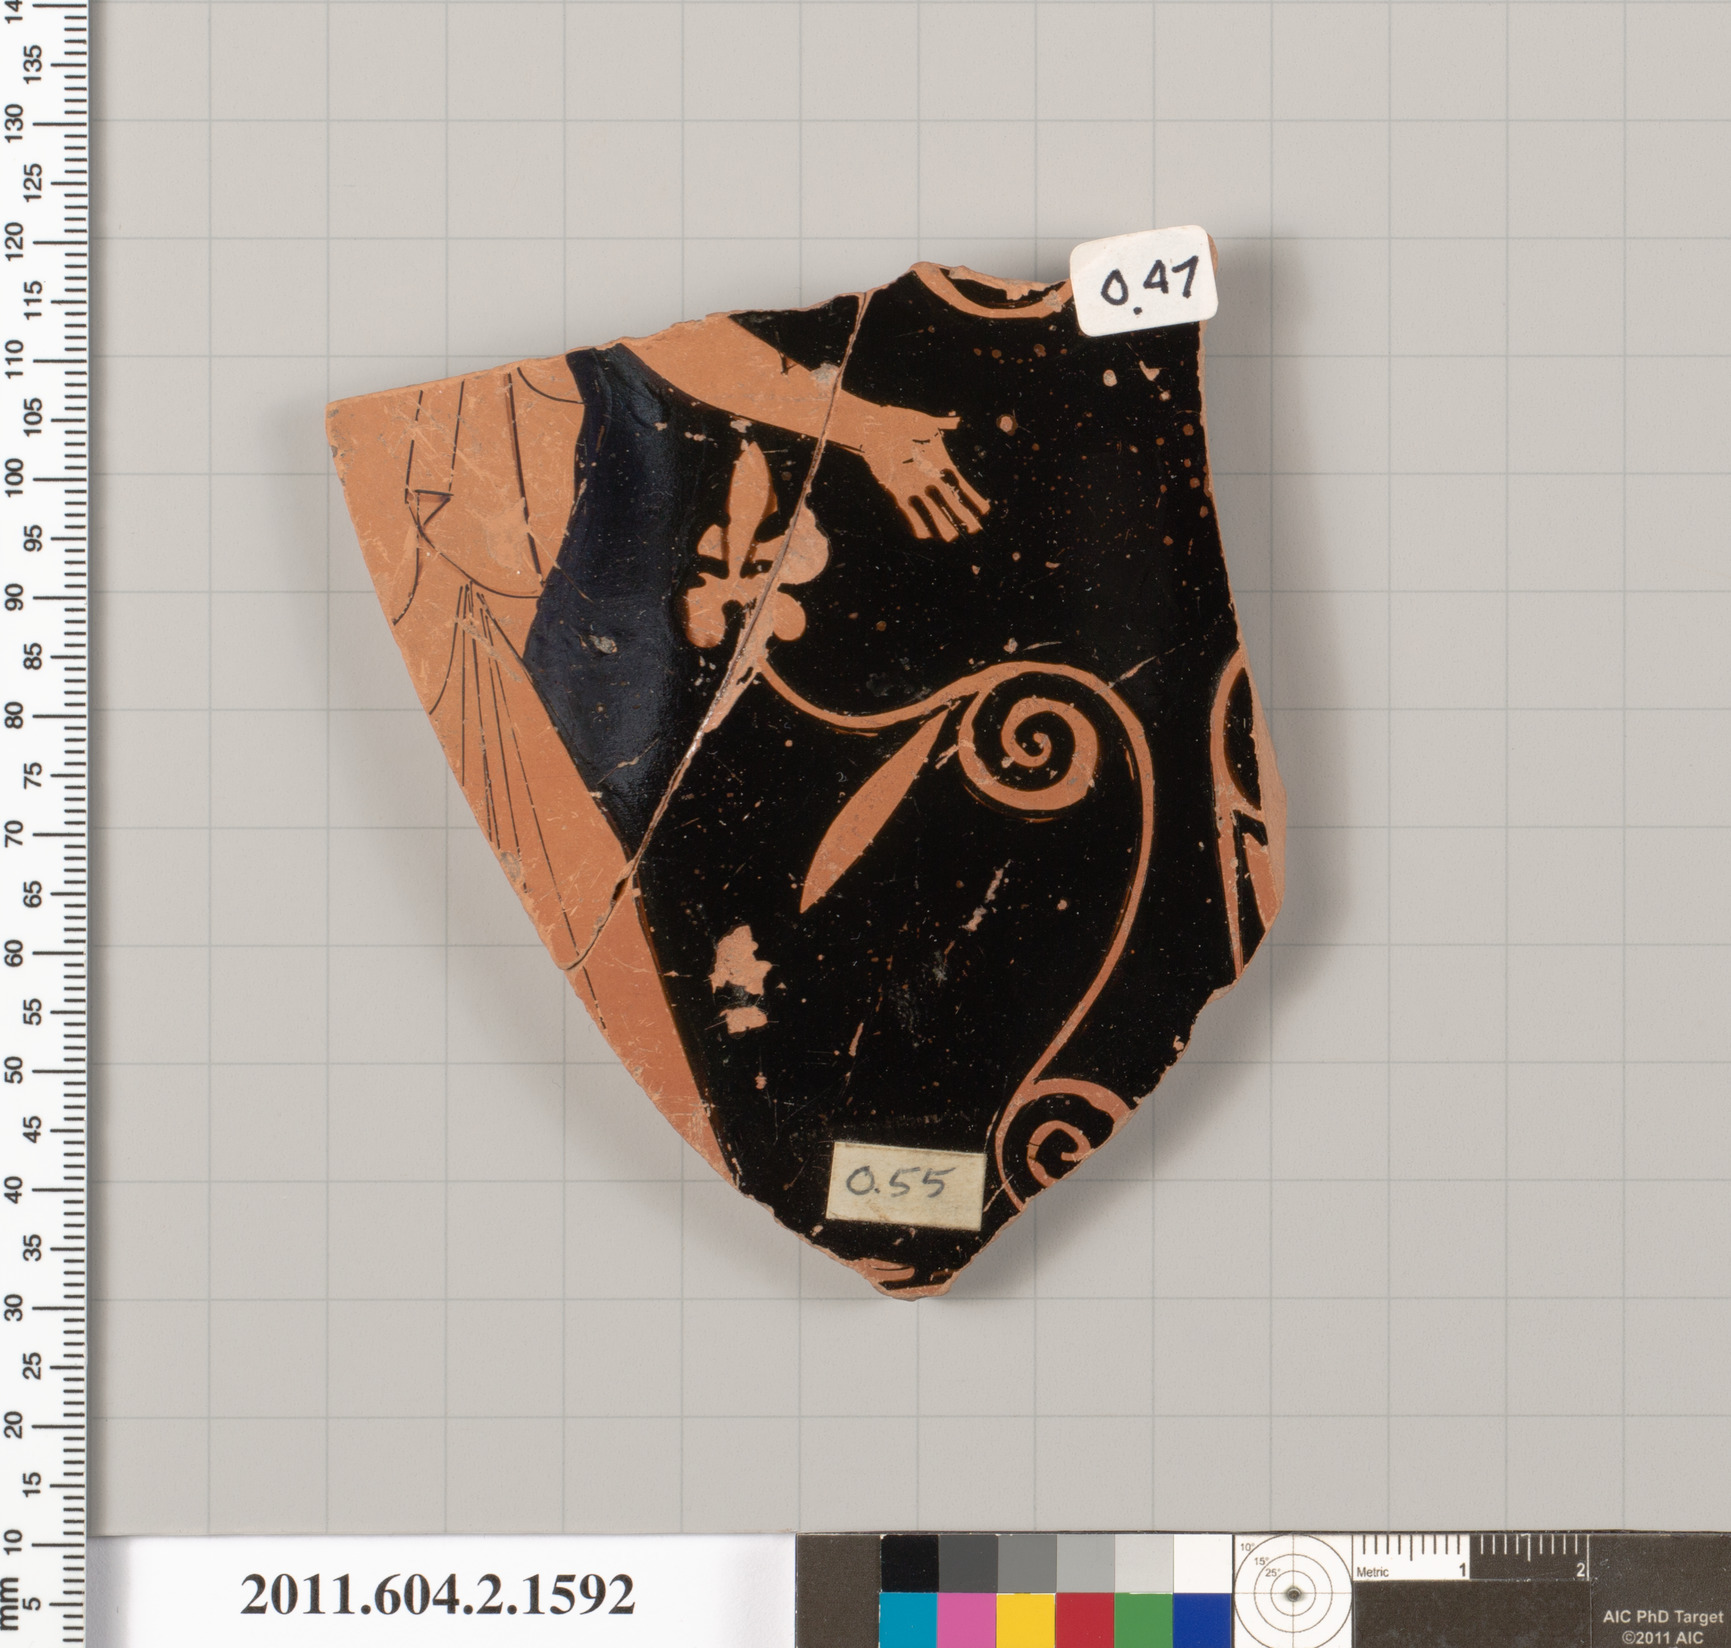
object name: skyphos fragment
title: Terracotta fragment of a skyphos (deep drinking cup)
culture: greek, attic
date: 475-451 BCE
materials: terracotta